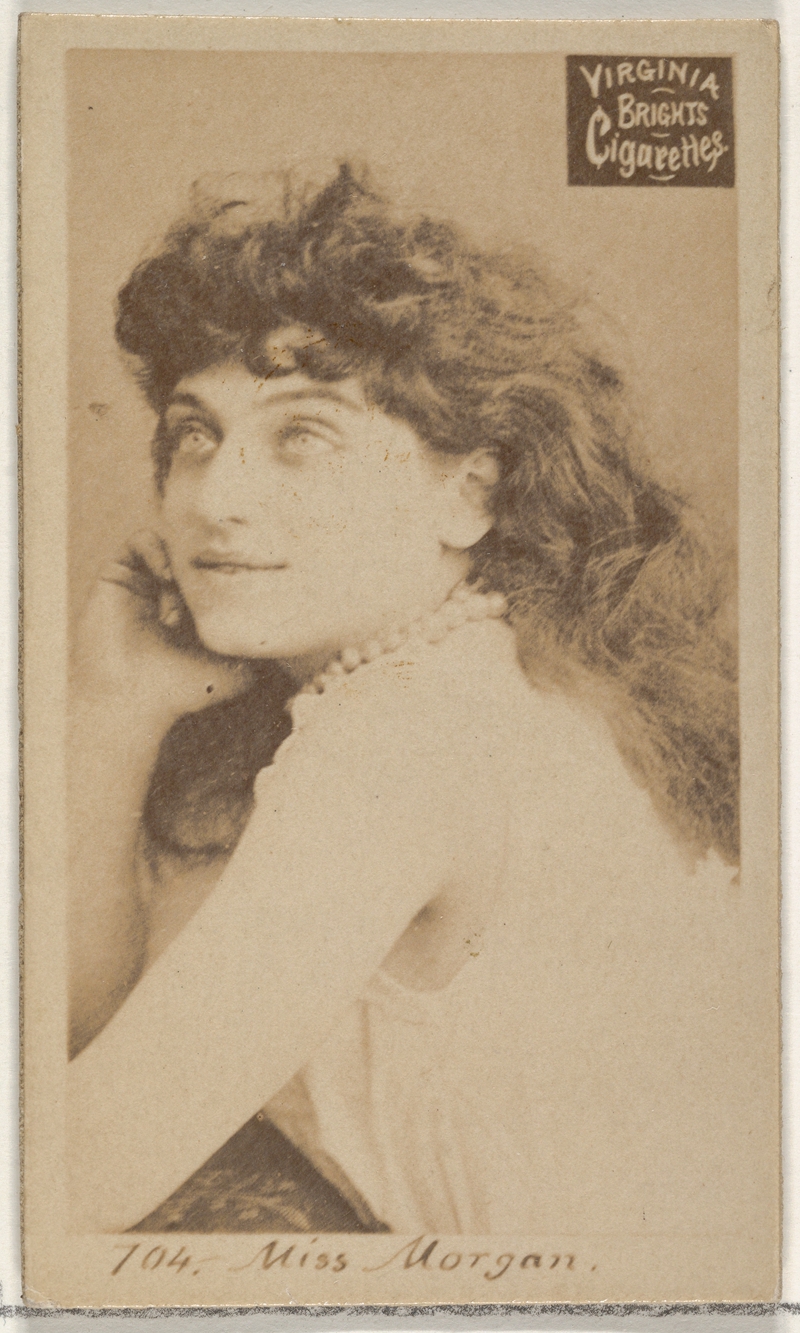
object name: photograph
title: Card 704, Miss Morgan, from the Actors and Actresses series (N45, Type 2) for Virginia Brights Cigarettes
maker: allen & ginter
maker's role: publisher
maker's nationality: american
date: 1888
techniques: albumen silver print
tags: portraits,women,actresses